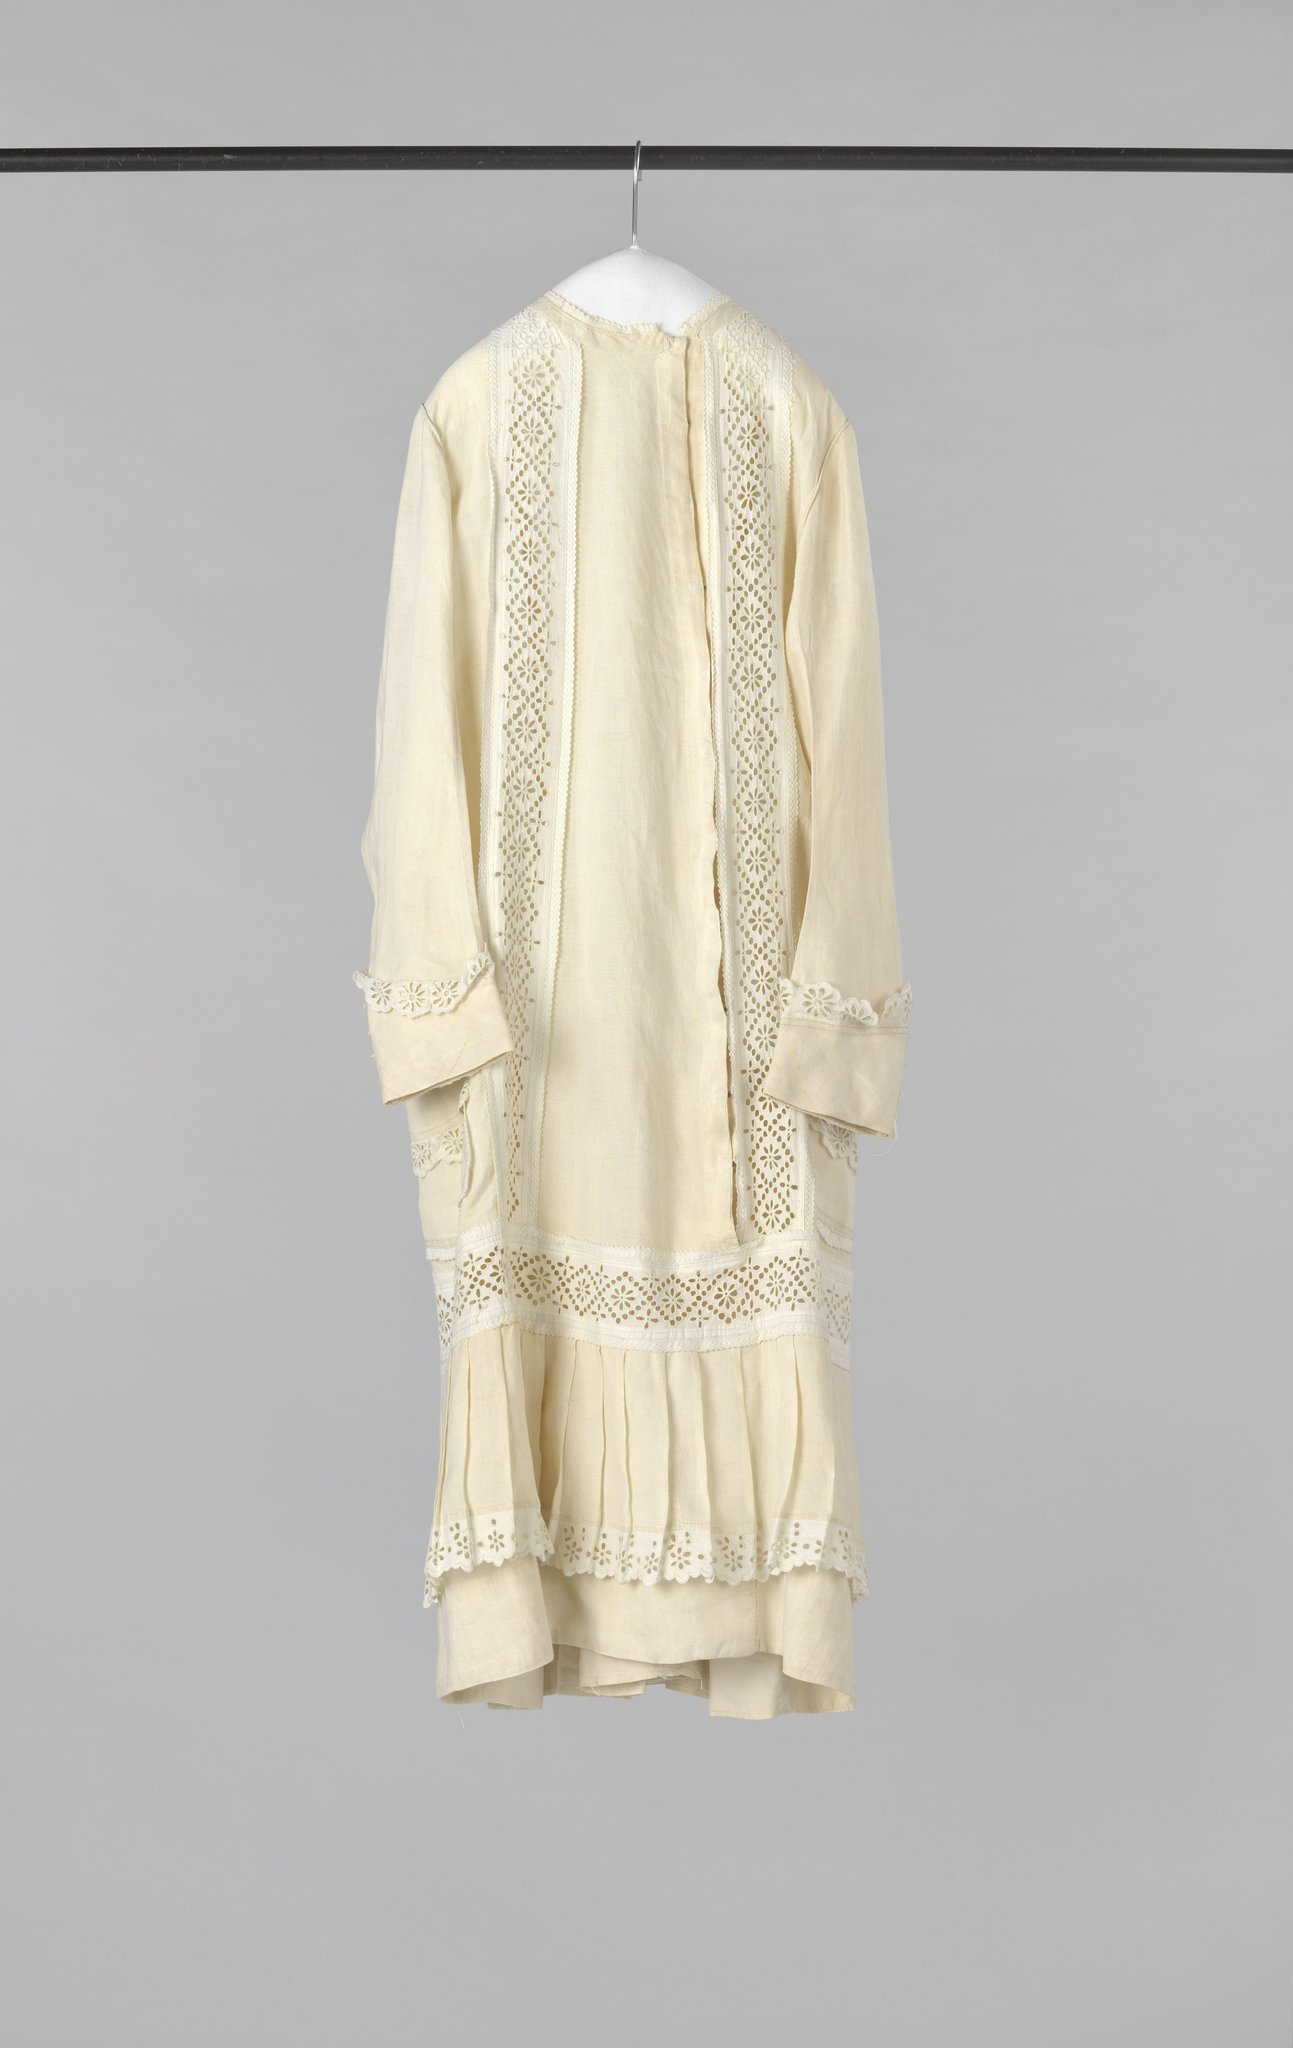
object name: girls' wear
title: Kinderjurk met lange mouw, van achter recht, van voren met zeer lage taille, sluiting, geplooide rok en twee steekzakken, van écru linnen, versierd met Engels borduurwerk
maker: Anonymous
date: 1875-1880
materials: linen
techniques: embroidered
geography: amsterdam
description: Een meisjesjurk van stevig, ecrukleurig linnen met opgenaaid wit Engels borduurwerk en galon. Victoriaans. Gedragen door Nine Bosch Reitz (1867-1951); later mevr. H. M. A. F. Six van Hillegom-Bosch Reitz. Op deze hanger werd een tros parelmoeren knopen (22 stuks) aangetroffen, die zich nu in VI-109 bevinden onder inv.nr. BK-TN-2342.